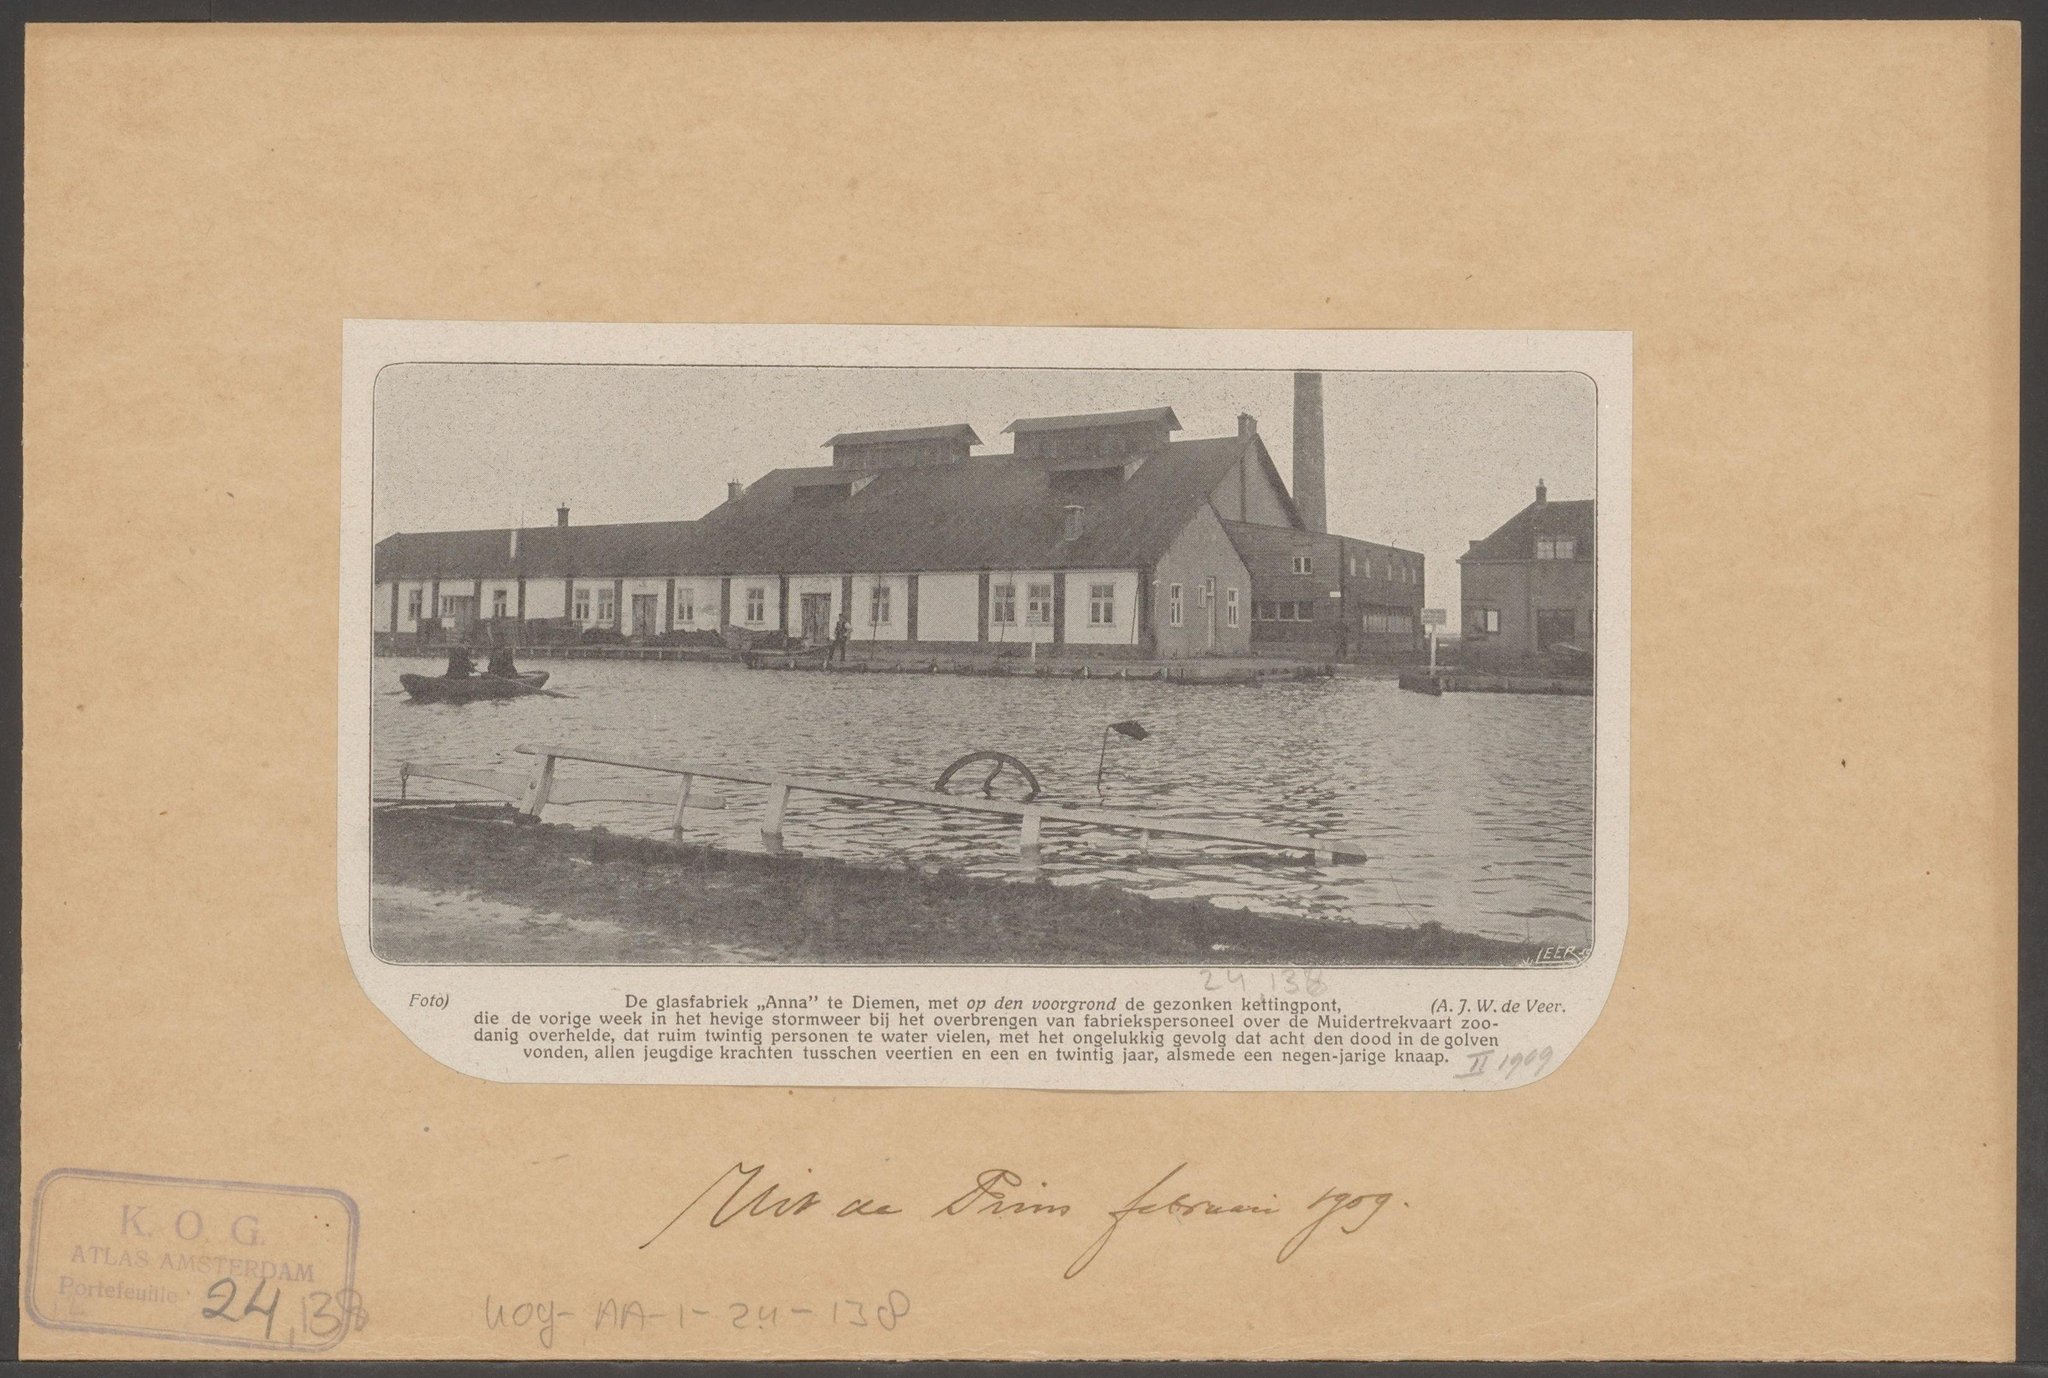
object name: photomechanical print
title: Gezicht op glasfabriek 'Anna' te Diemen en een gezonken kettingveerpont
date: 1902-1909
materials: paper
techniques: letterpress printing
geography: amsterdam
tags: factory-building, sinking (movement in water), death by drowning (non-violent)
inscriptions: collector's mark: Lugt 1641b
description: Onderwerpsrubriek binnen de Atlas Amsterdam: Ongelukken.